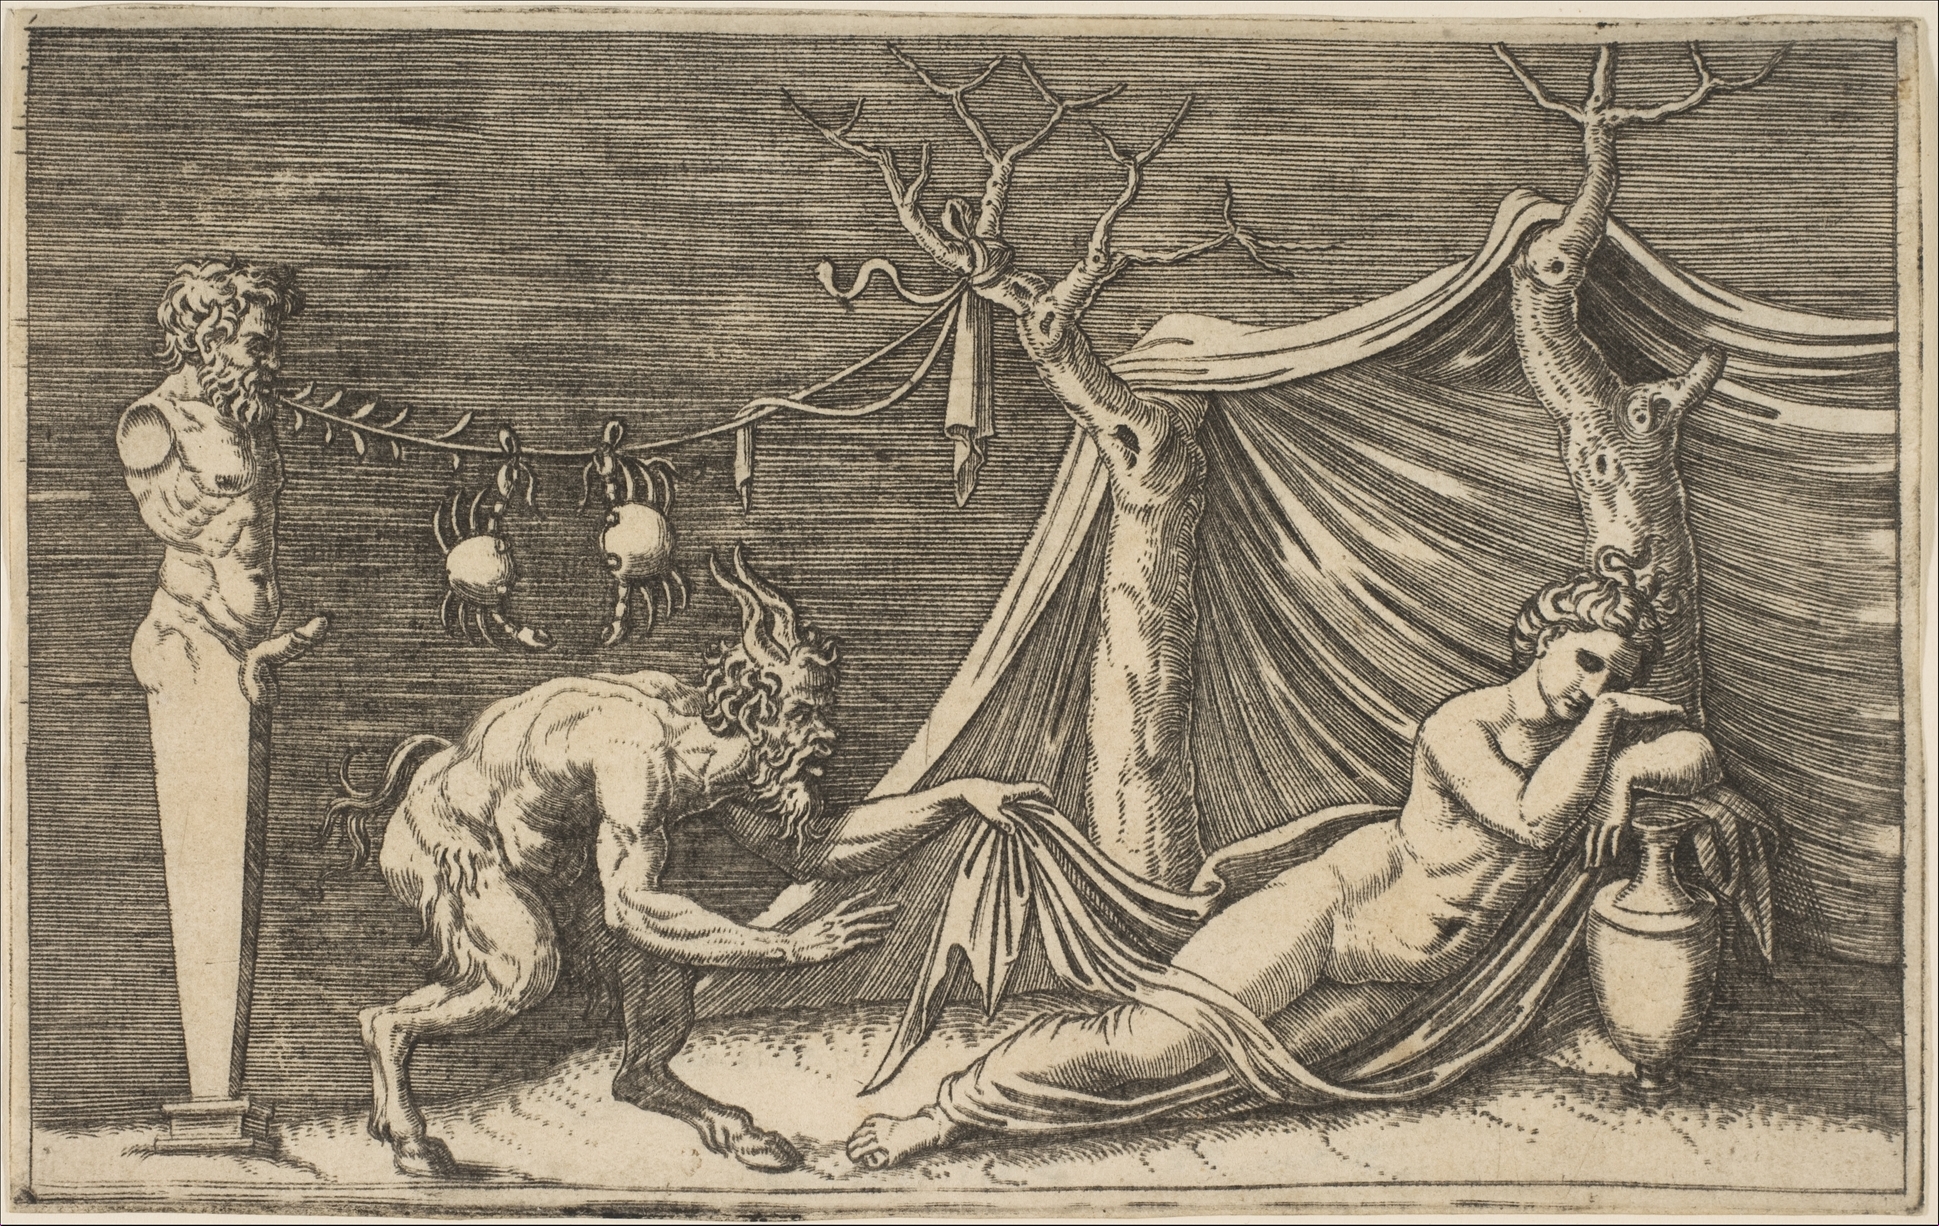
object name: print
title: A satyr discovering a sleeping woman; two crabs hanging from a rope which is strung between a term and a tree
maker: marco dente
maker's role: artist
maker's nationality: italian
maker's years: 1515-1527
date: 1515-1527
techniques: engraving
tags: sleeping,women,satyrs,crabs,trees